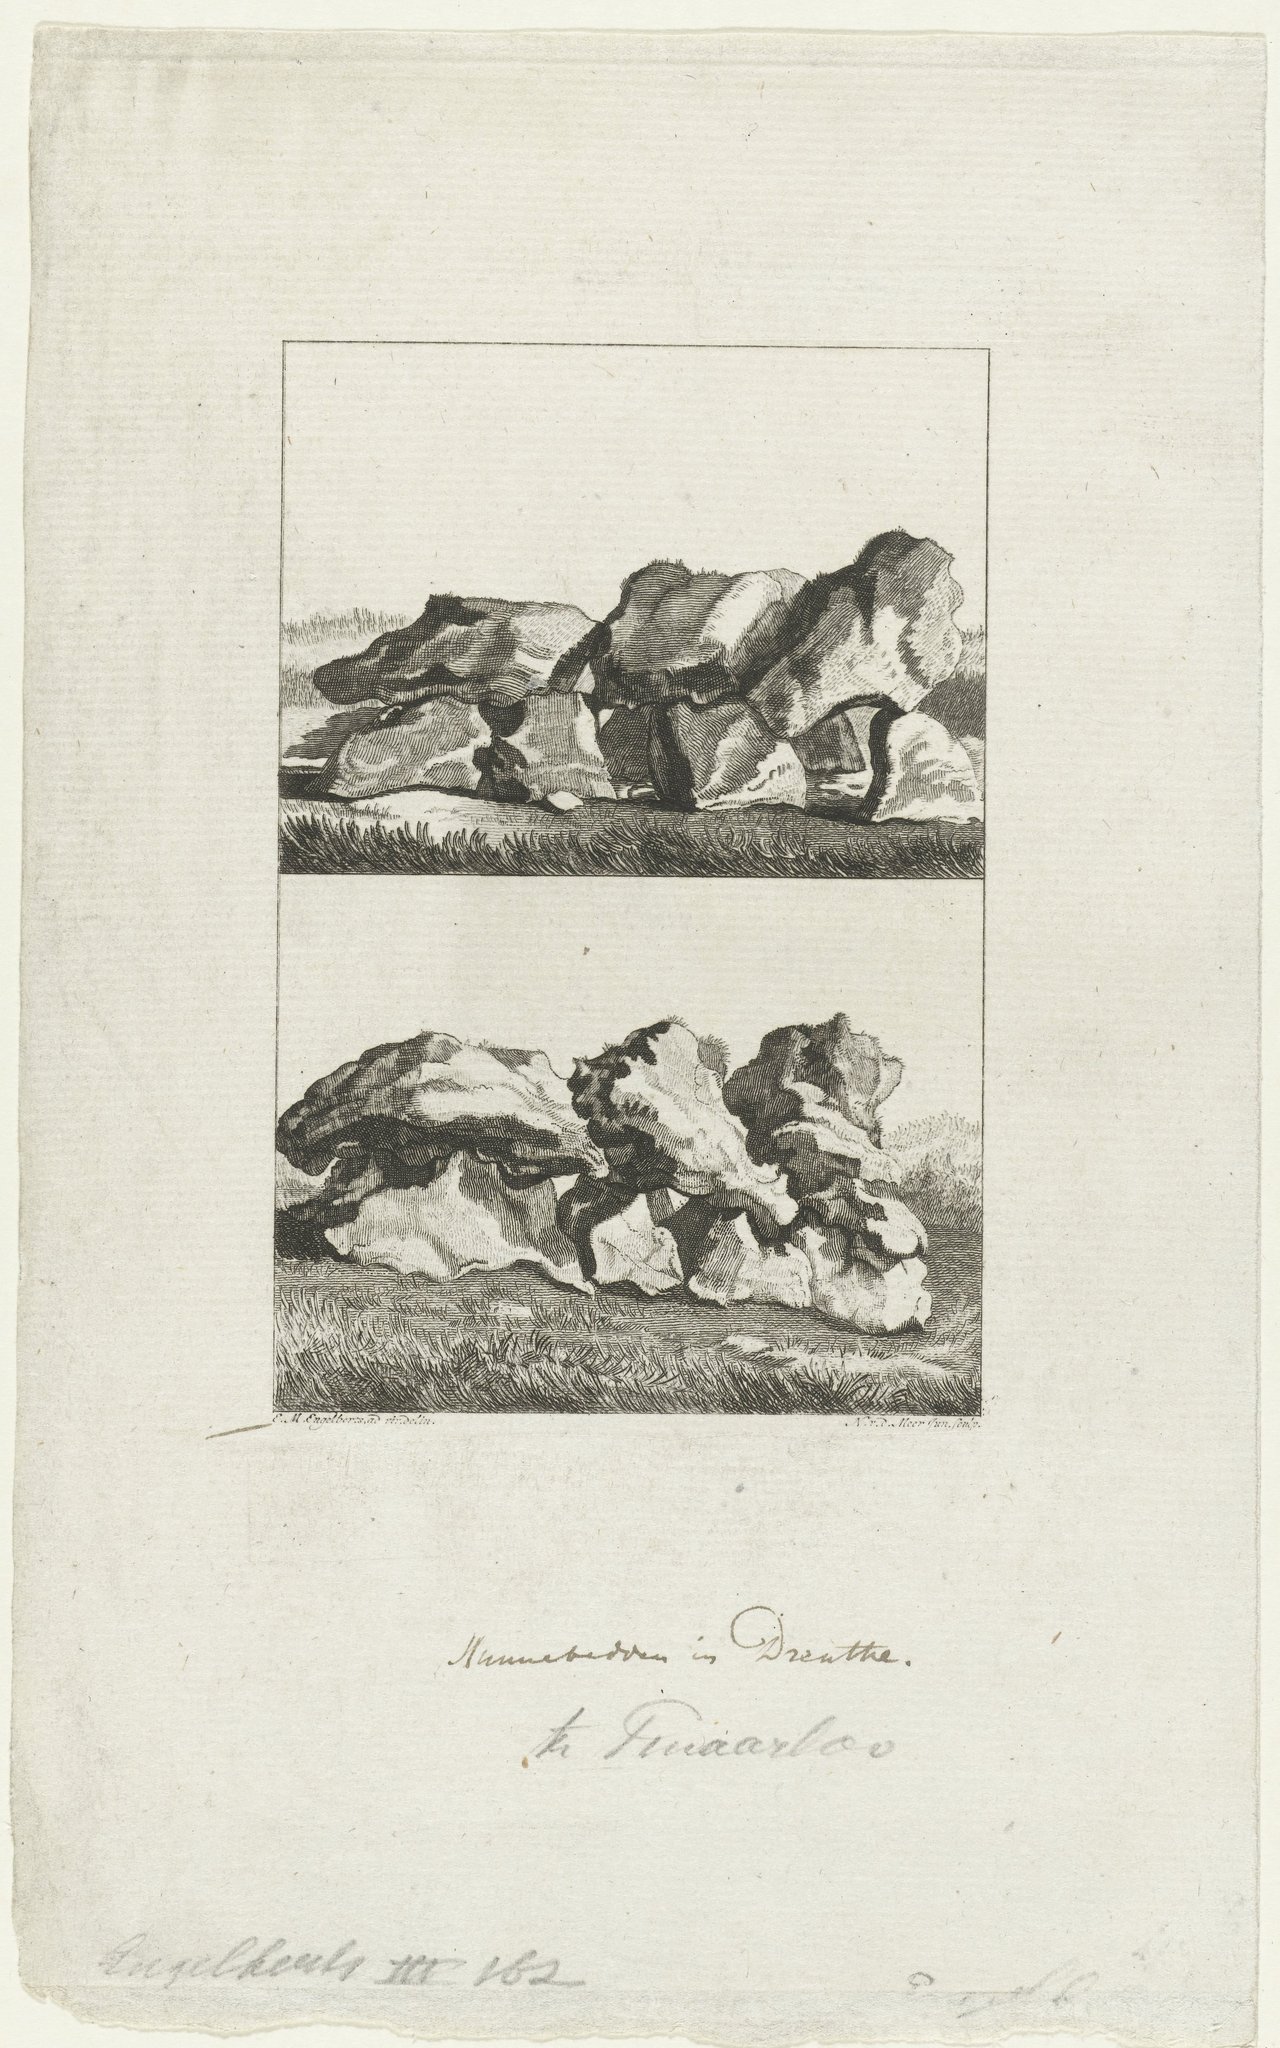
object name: historical object representation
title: Hunebedden bij Tinaarlo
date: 1788-1790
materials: paper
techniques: etching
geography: netherlands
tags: prehistoric grave forms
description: Illustratie voor: E.M. Engelberts, De aloude staat en geschiedenissen der Vereenigde Nederlanden, Johannes Allart, Amsterdam 1784-1799, dl. III, p. 162. Staat vóór de letter.